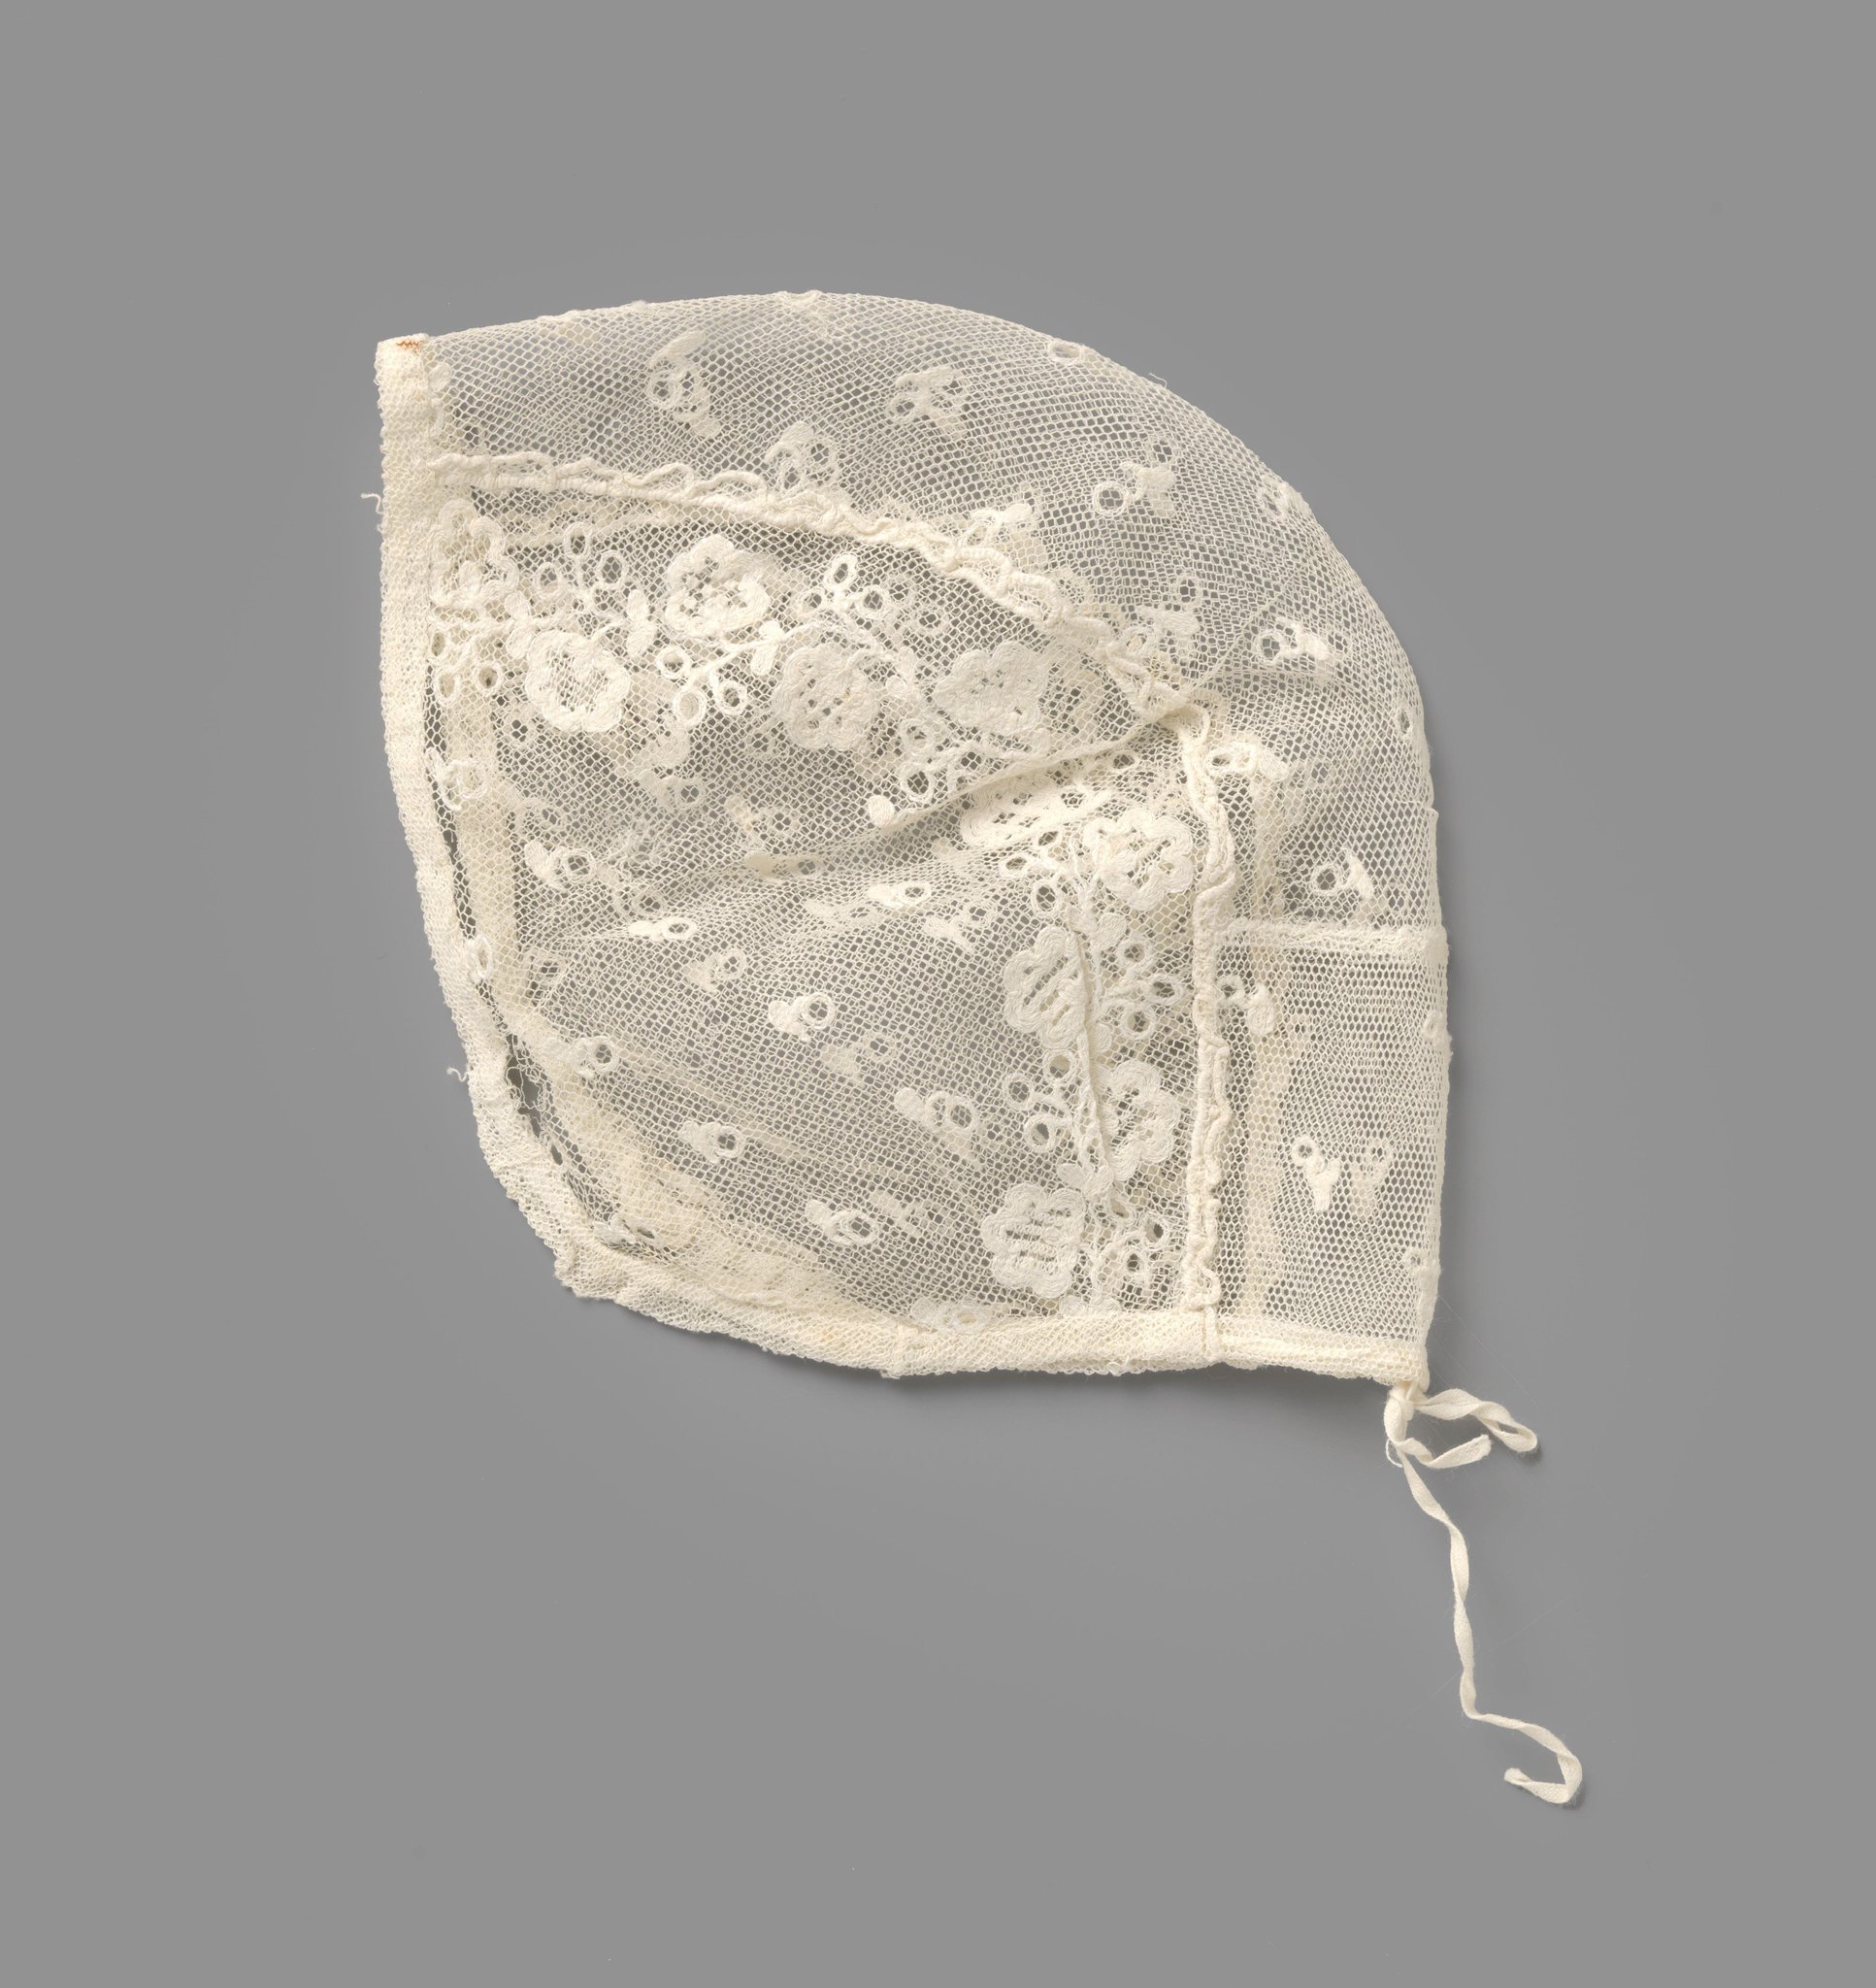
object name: cap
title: Kindermuts van witte tule met wit borduurwerk, dat een strooimotief en aan weerszijden van het midden bloemranken vertoont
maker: Anonymous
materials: fiber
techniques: embroidered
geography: europe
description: Kindermuts van witte tule met wit borduurwerk, dat een strooimotief en aan weerszijden van het midden bloemranken vertoont.